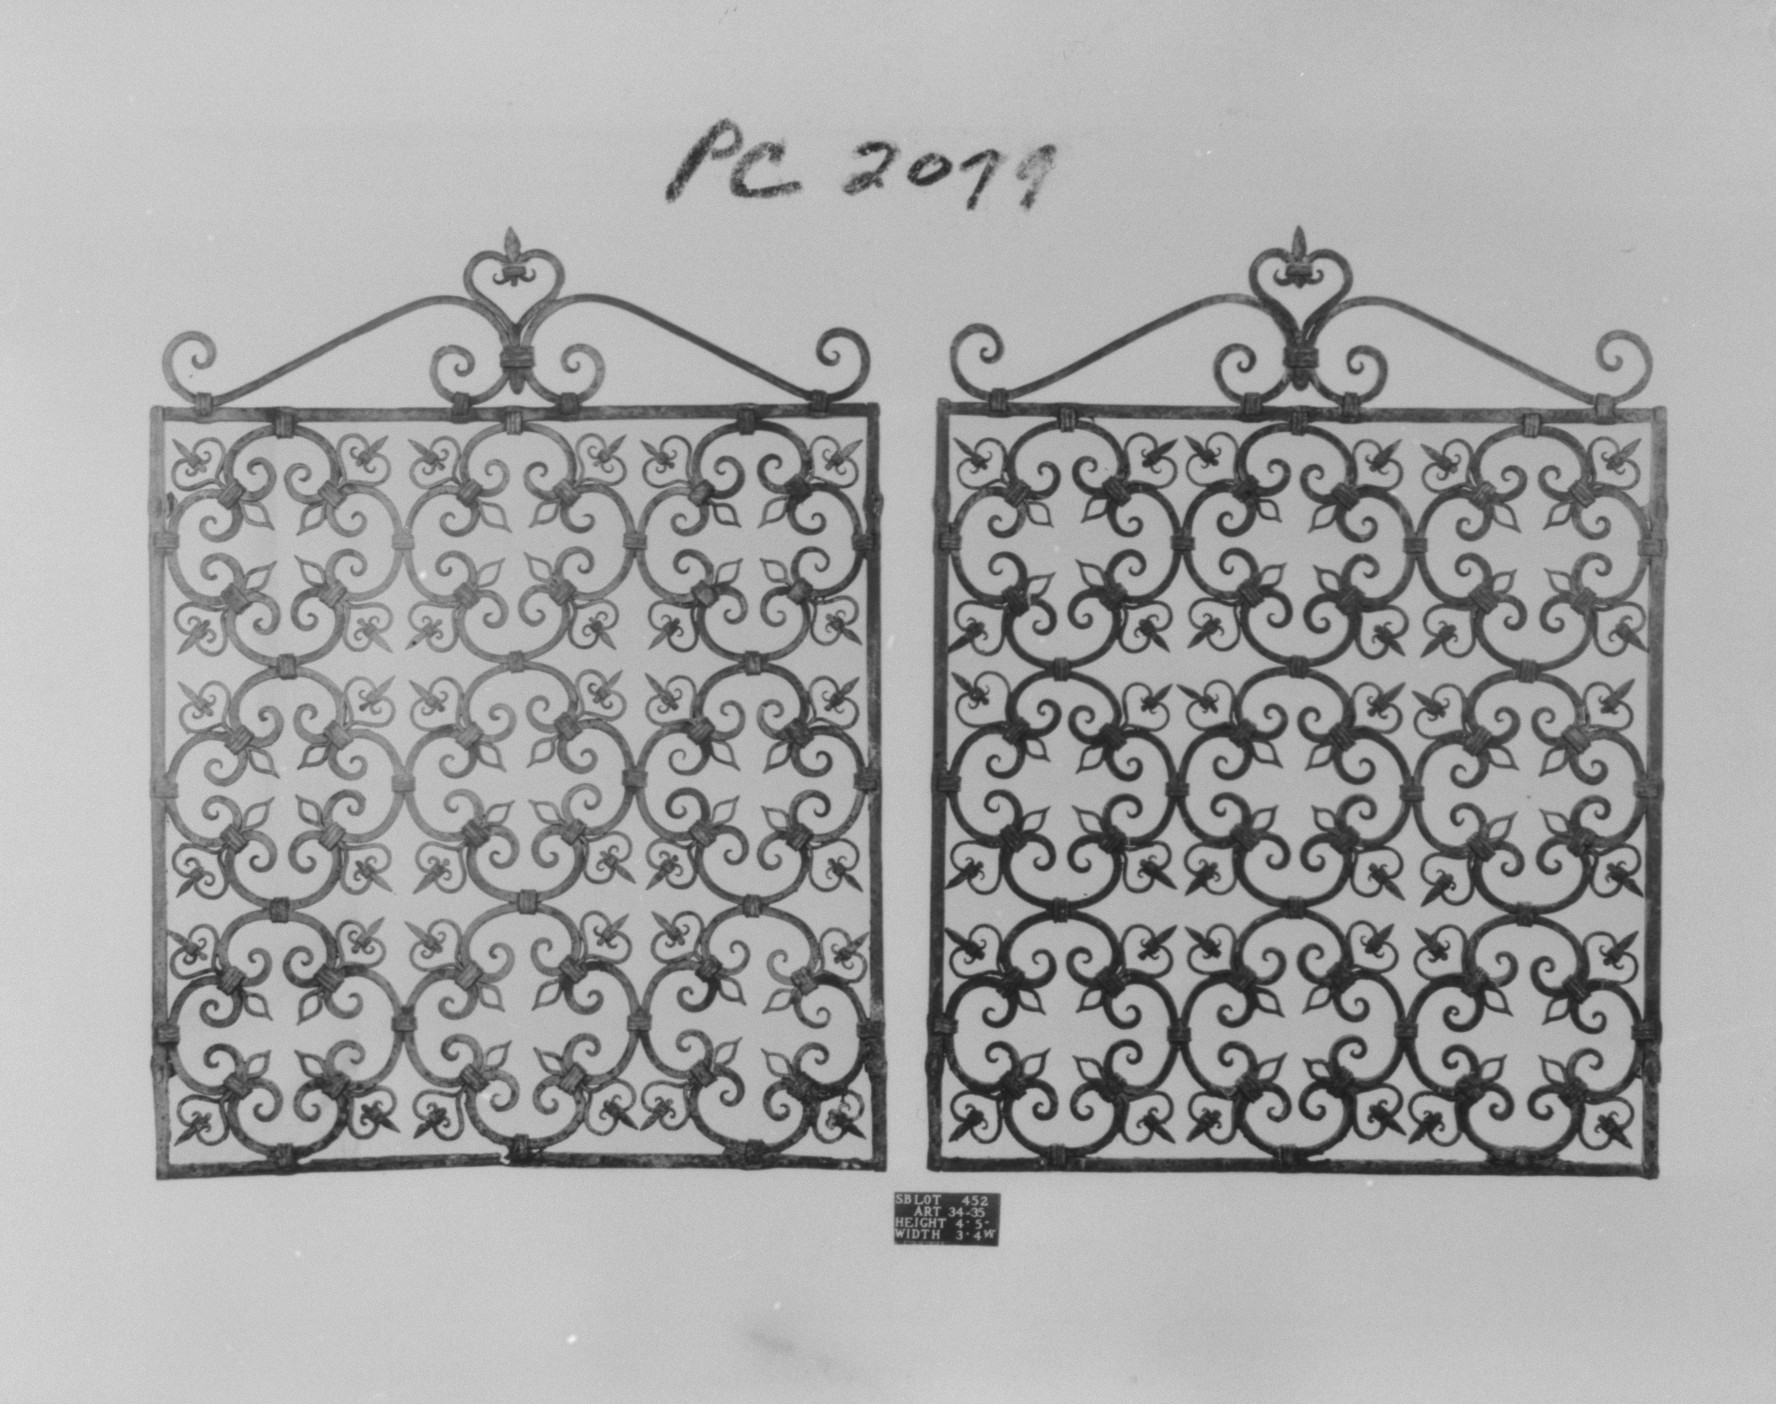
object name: window guard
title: Pair of window guards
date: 1601-1700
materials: iron